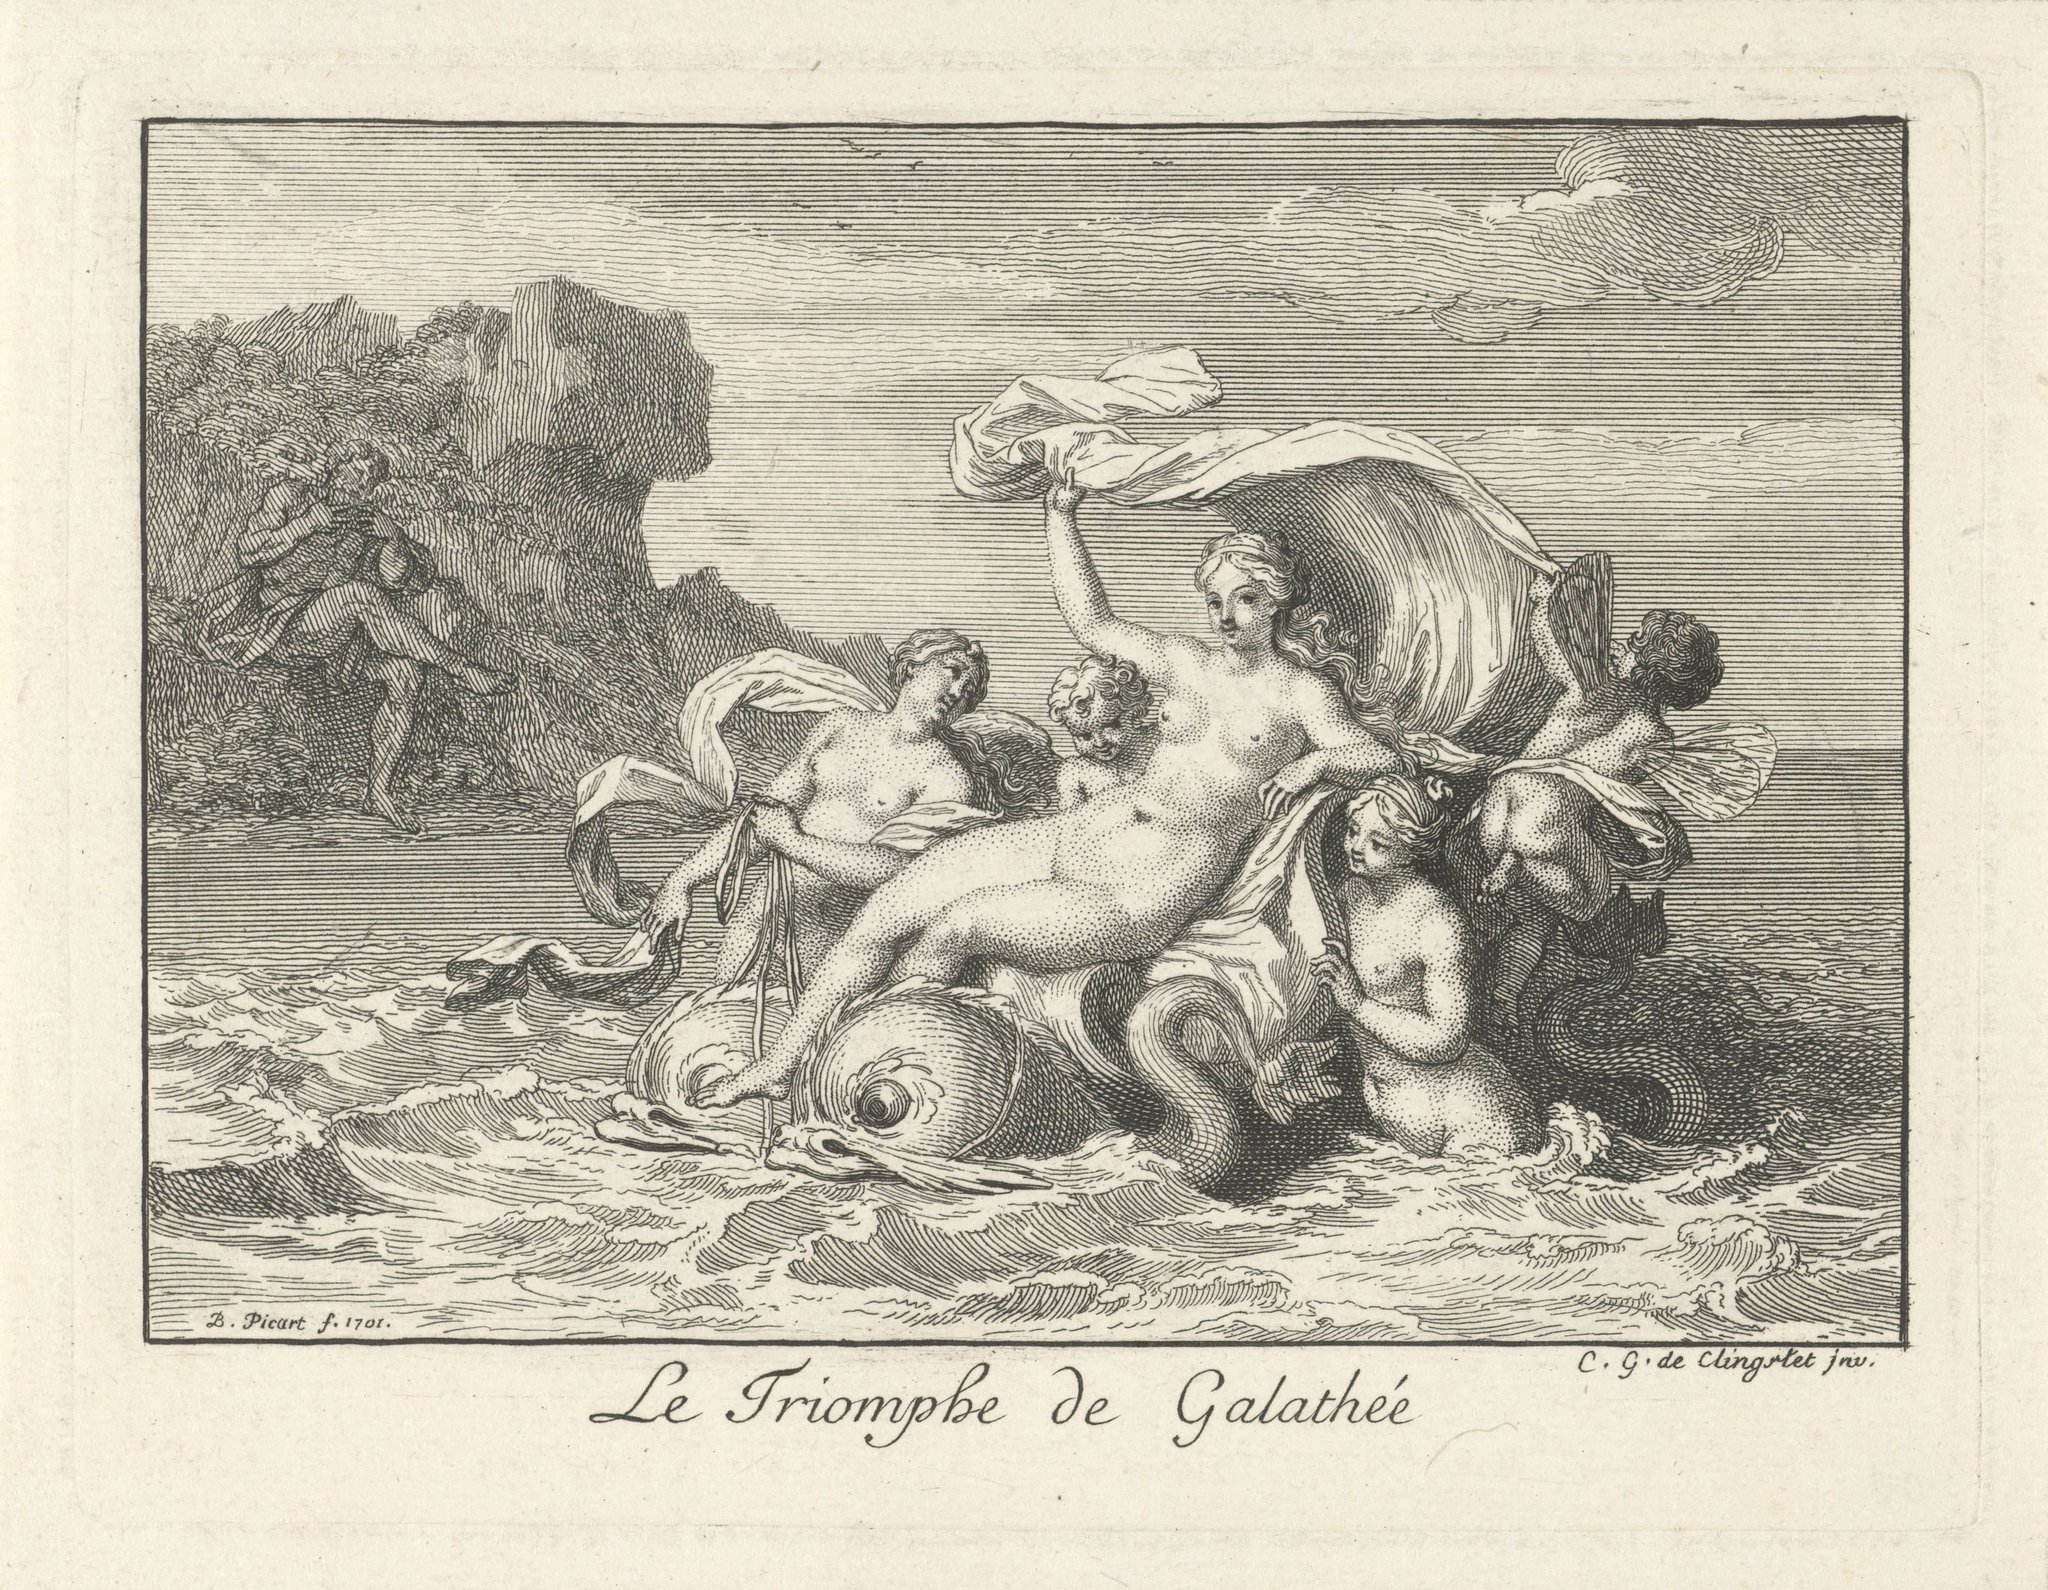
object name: print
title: Triomf van Galatea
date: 1701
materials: paper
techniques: engraving, etching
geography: paris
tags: triumph of galatea, polyphemus playing the syrinx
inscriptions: collector's mark: Lugt 240, collector's mark: Lugt 2228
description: De zeenimf Galatea rust achterover op een wagen, voortgetrokken door vissen. Ze wordt omringd door nimfen en putti. In de lucht zweeft Polyphemus die op zijn panfluit een liefdeslied voor haar speelt.